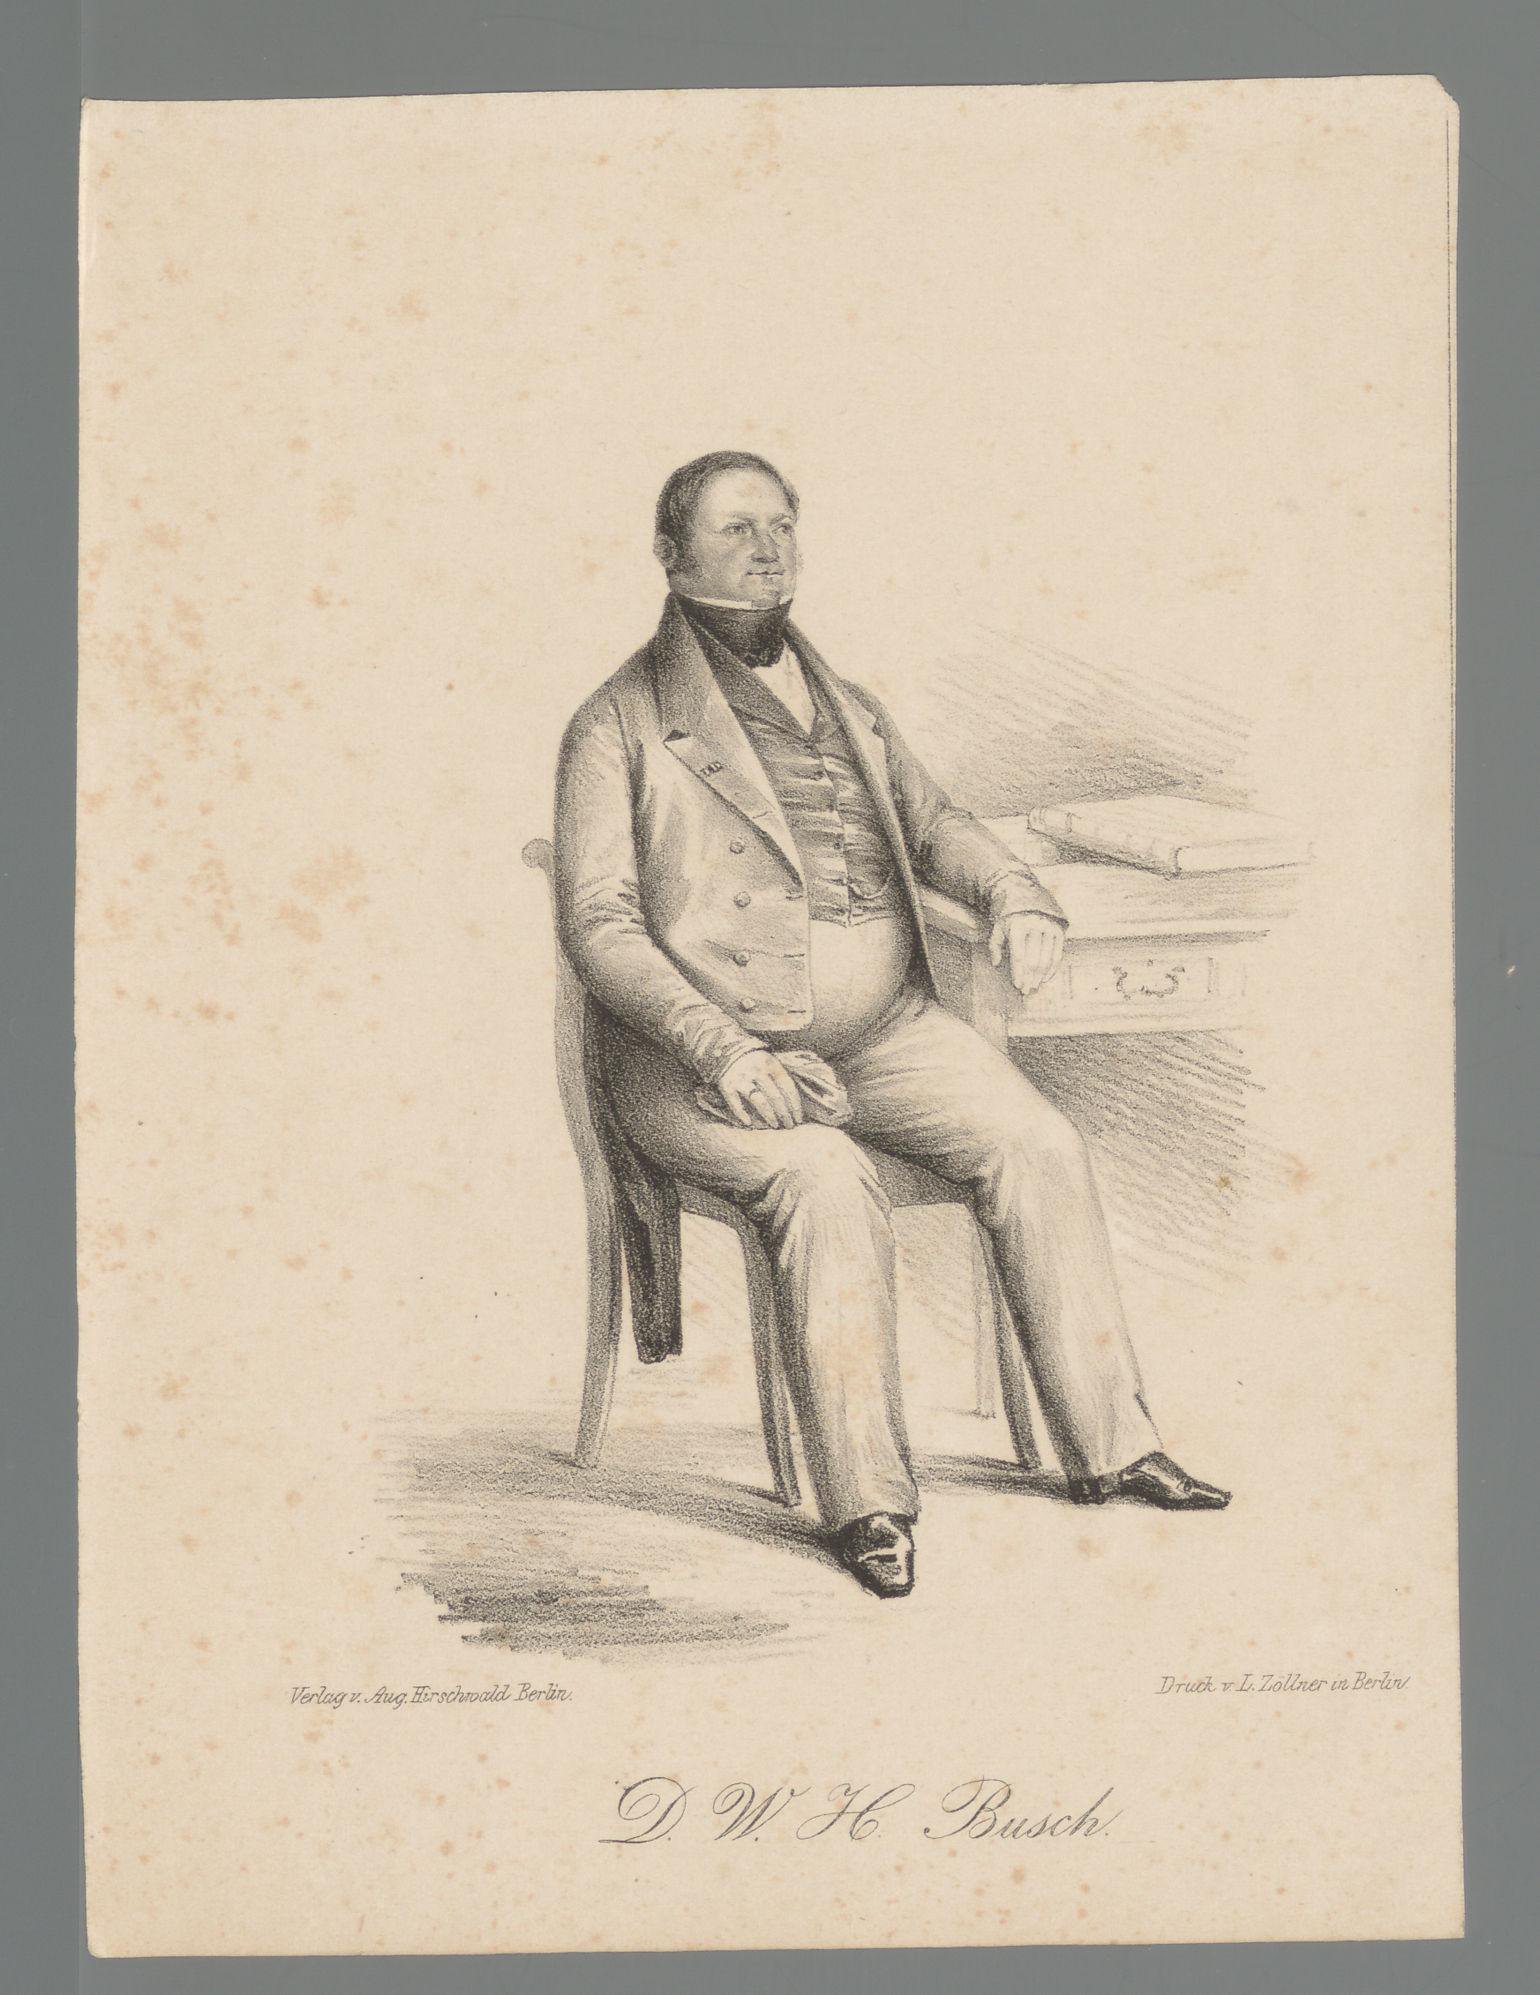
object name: print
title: D.W.H. Busch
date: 1820-1860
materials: paper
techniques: lithograph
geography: berlin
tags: adult man, historical persons, table, chair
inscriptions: collector's mark: Lugt 2228